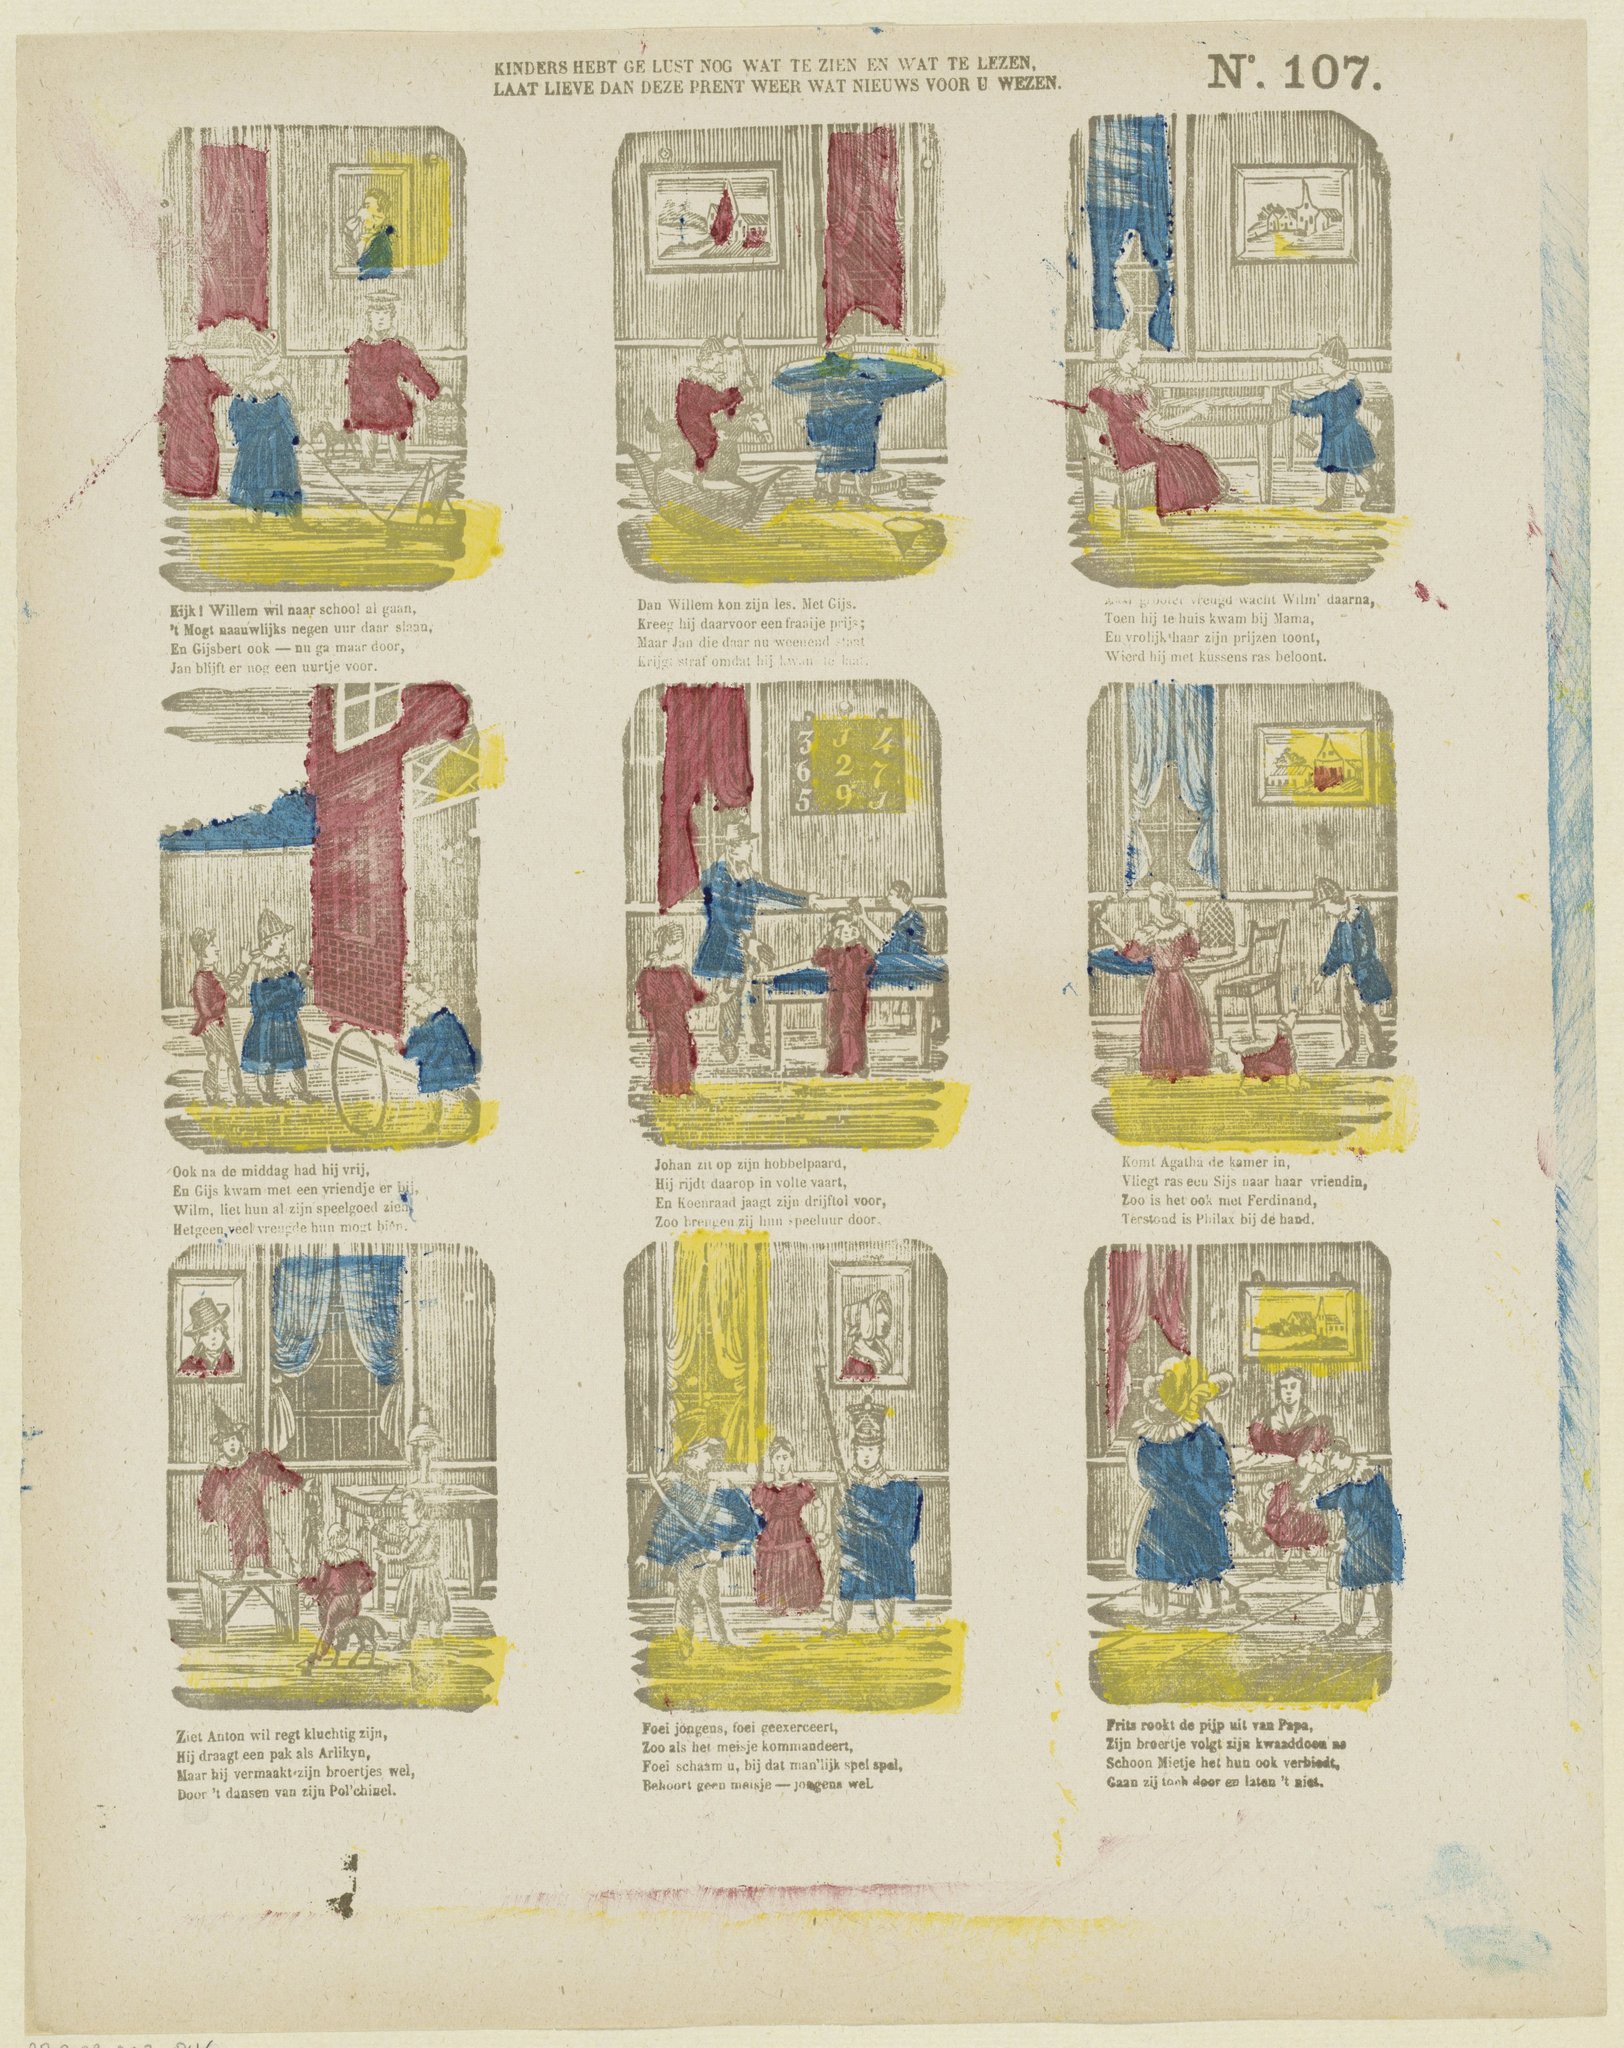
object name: print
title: Kinders hebt ge lust nog wat te zien en wat te lezen, / Laat lieve dan deze prent weer wat nieuws voor u wezen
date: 1827-1894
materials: paper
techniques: printing, colour, letterpress printing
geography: schaarbeek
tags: children's games and plays, games using special objects (marbles, top, hoop, etc.), rocking-horse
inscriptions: collector's mark: Lugt 2760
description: Blad met 9 voorstellingen van kinderspelen, zoals hobbelpaardje rijden, hoepelen en soldaatje spelen. Onder elke afbeelding een vierregelig vers. Genummerd rechtsboven: No. 107.